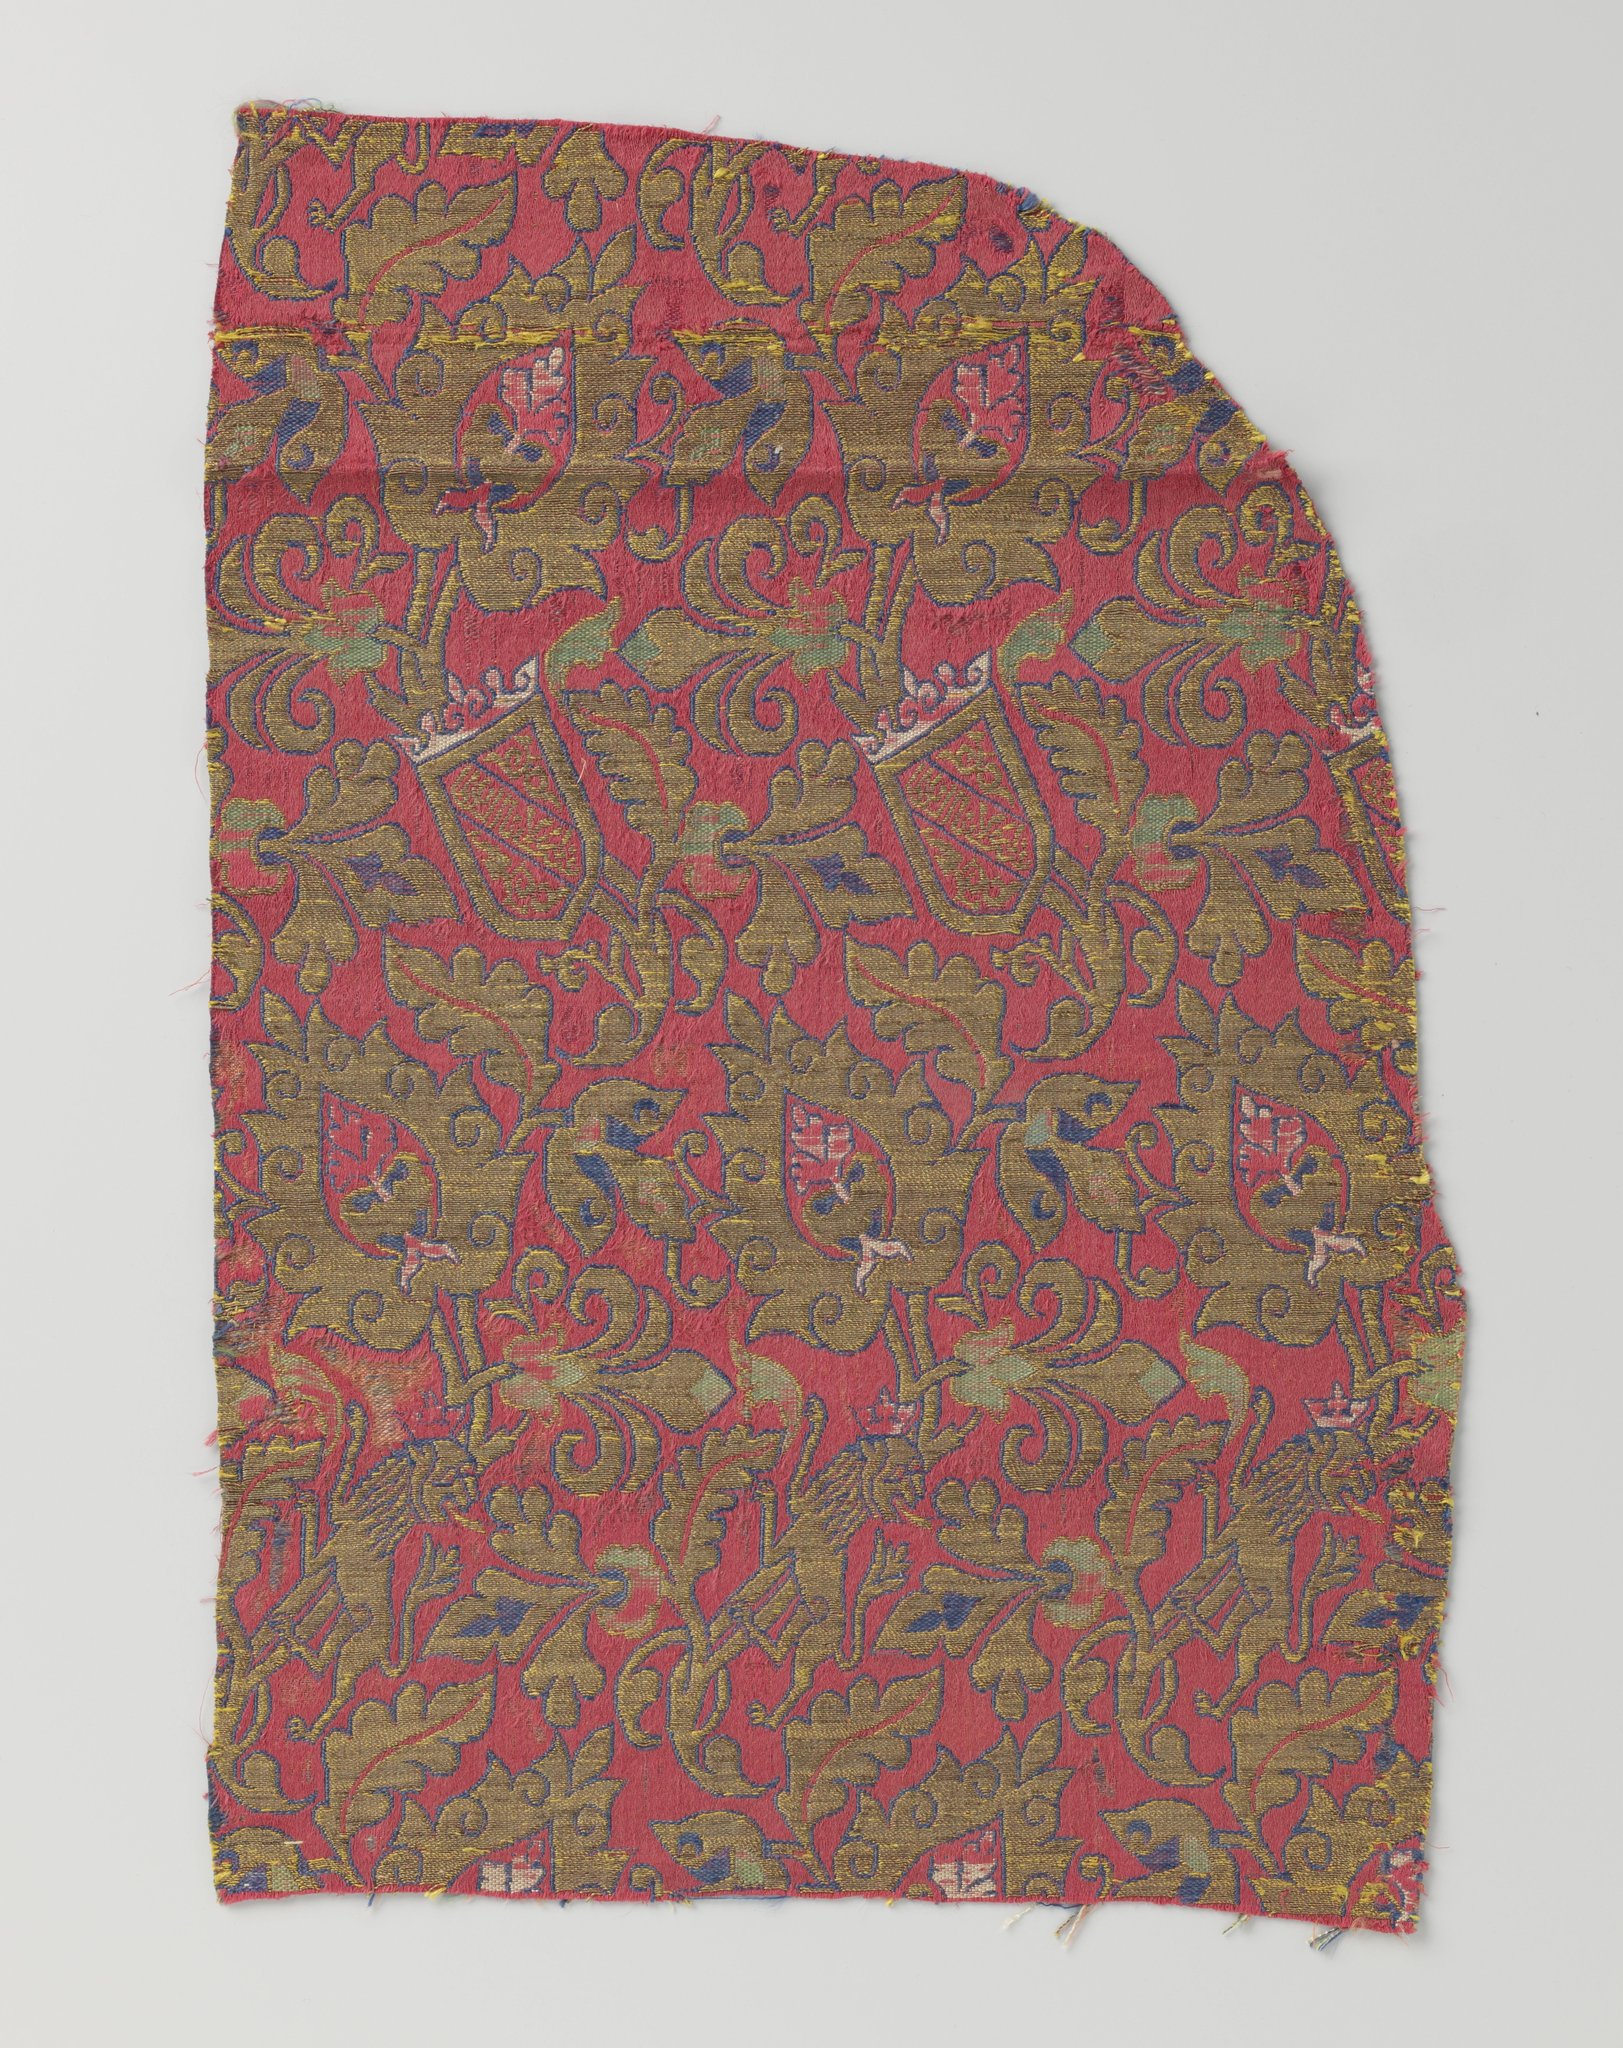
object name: fragment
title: Fragment rode lampas met patroon van gestileerd bladeren, leeuwen en het wapen van Granada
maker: Anonymous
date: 1300-1599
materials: silk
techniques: lampas, weave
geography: spain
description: Fragment rode lampas met patroon in blauw, groen, wit en goud van gestileerd bladeren en bloemen en dito leeuwen met omgewende kop, alsmede gekroonde wapenschilden met diagonale balk (het wapen van Granada met bladeren).